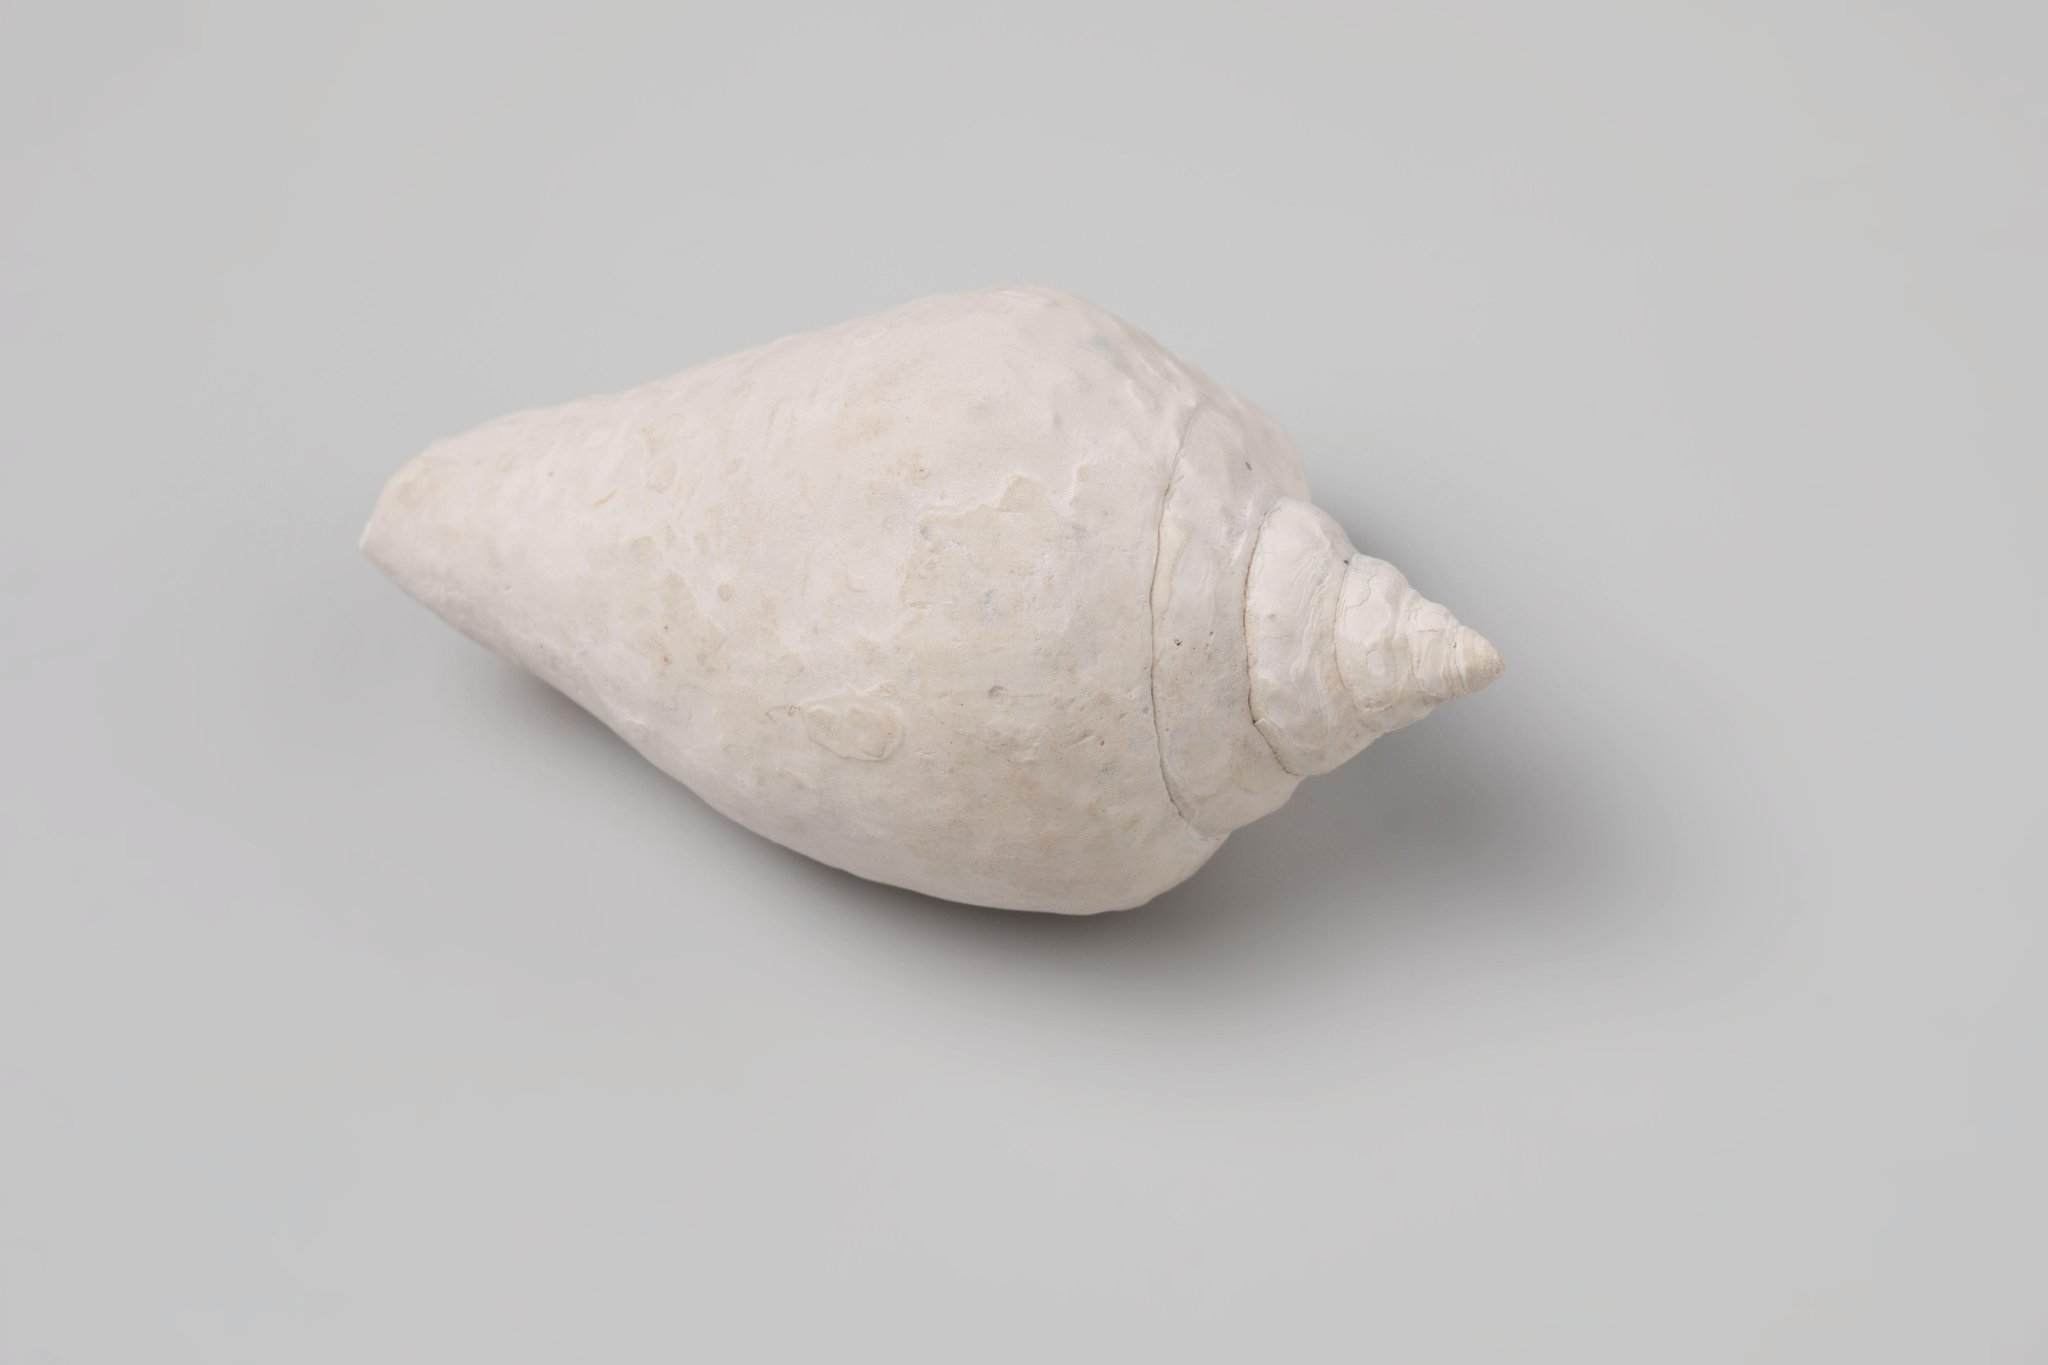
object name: strombus canarium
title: Strombus canarium shell from the wreck of the Dutch East India ship Witte Leeuw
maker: niet van toepassing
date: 1613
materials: shell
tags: verenigde oostindische compagnie, sint-helena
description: Schelp uit V.O.C.-schip de 'Witte Leeuw'.